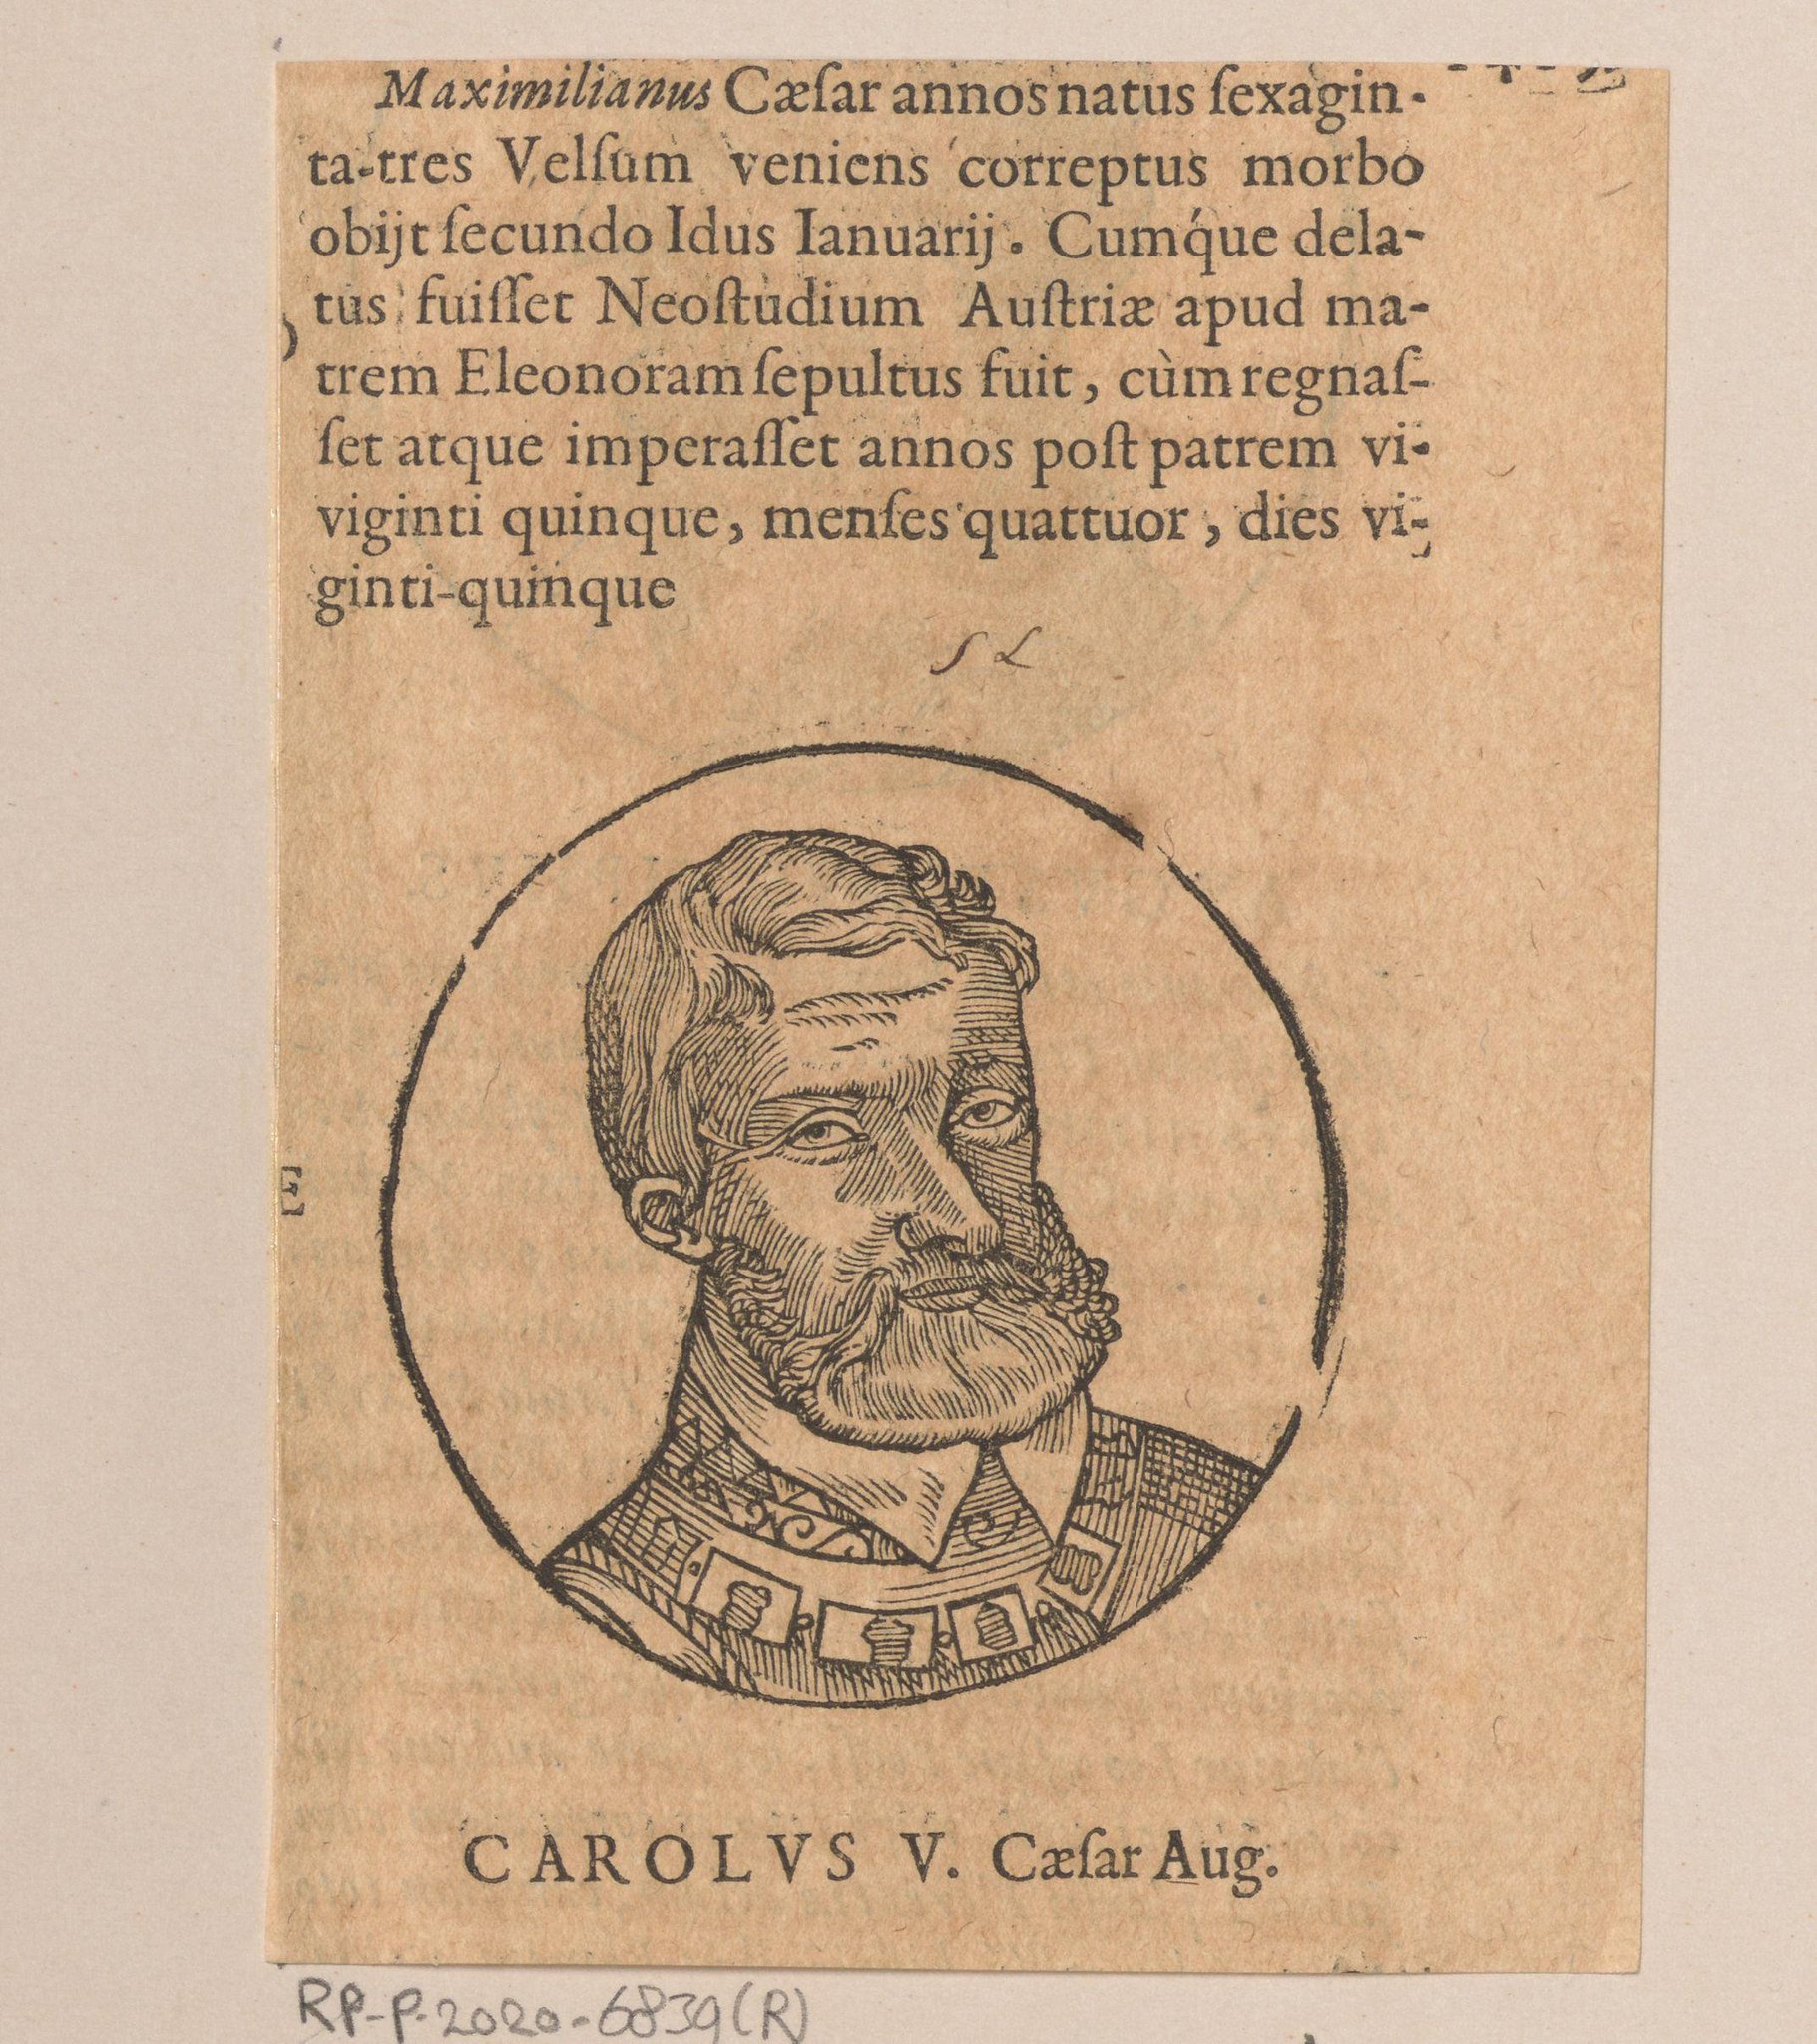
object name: book illustration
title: Portret van keizer Karel V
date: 1611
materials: paper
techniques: letterpress printing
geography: antwerp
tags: ghent, charles v (holy roman emperor and king of spain), historical persons, king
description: Prent uit: Opmeer, Pieter. Opus chronographicum orbis universi a mundi exordio (...). Antwerpen: Hieronymus Verdussen, 1611.